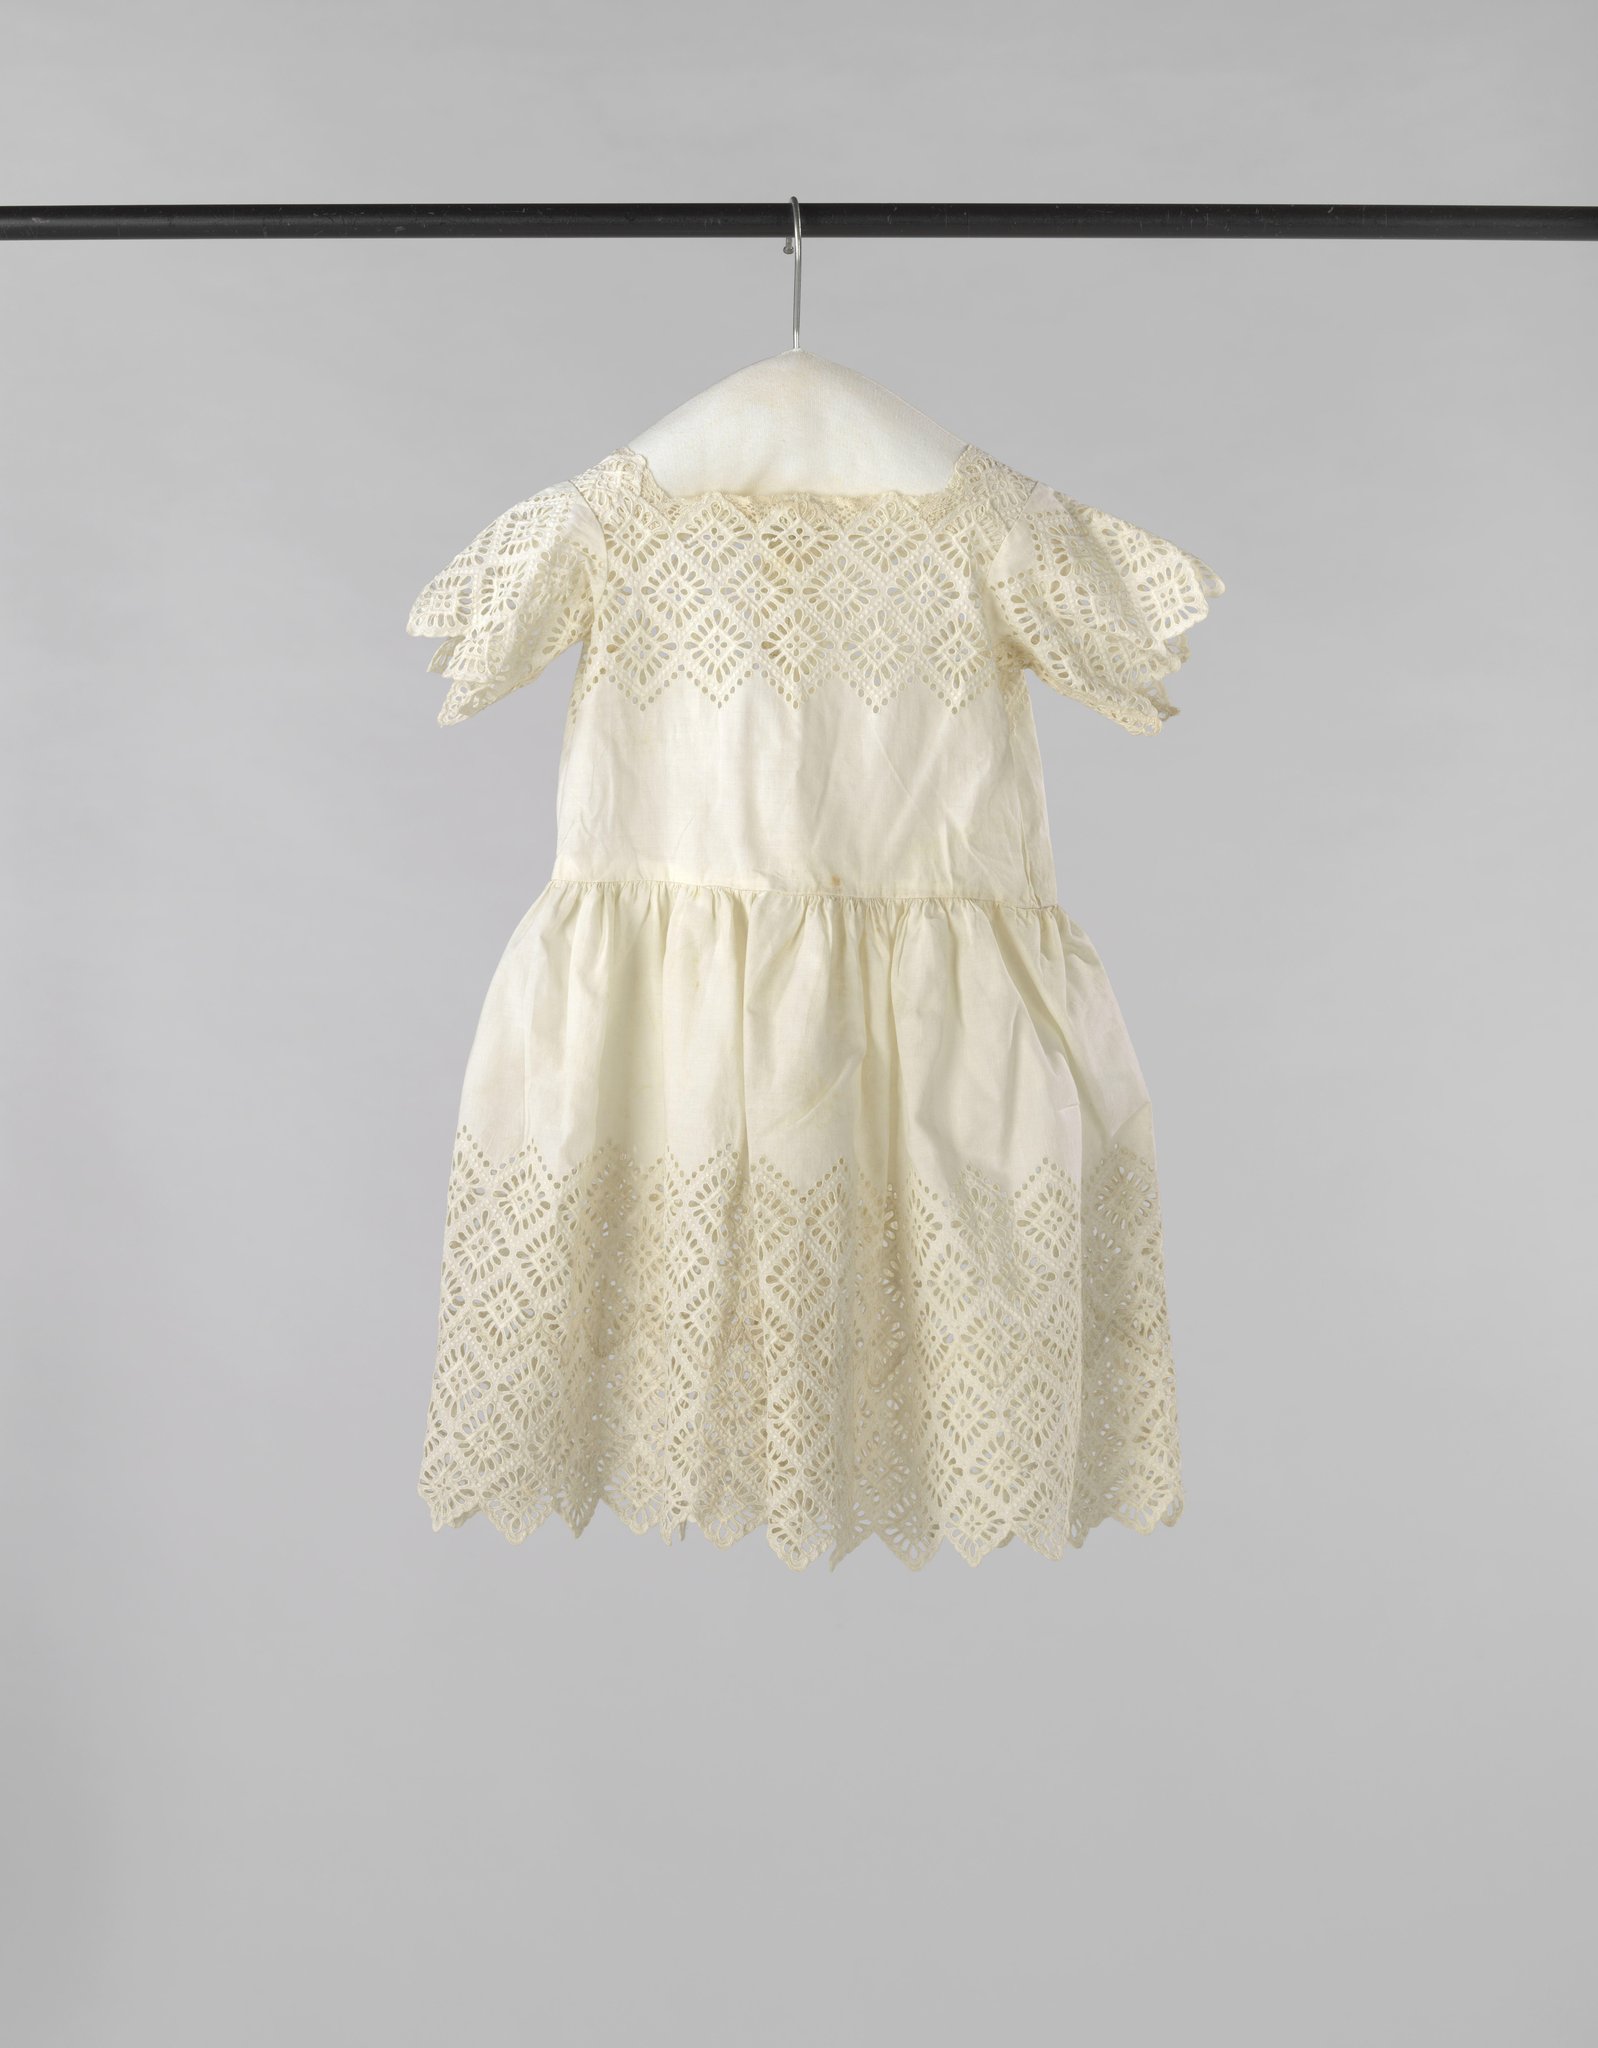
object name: main garment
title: Kinderjurk van wit katoen, met korte mouw van Engels borduurwerk en langs bovenkant lijf en groot deel van de rok ook met Engels borduurwerk; achter 8 parelmoeren knopen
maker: Anonymous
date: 1880-1920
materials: cotton, mother of pearl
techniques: embroidered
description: Kinderjurk van wit katoen, met korte mouw van Engels borduurwerk en langs bovenkant lijf en groot deel van de rok ook met Engels borduurwerk; achter 8 parelmoeren knopen.